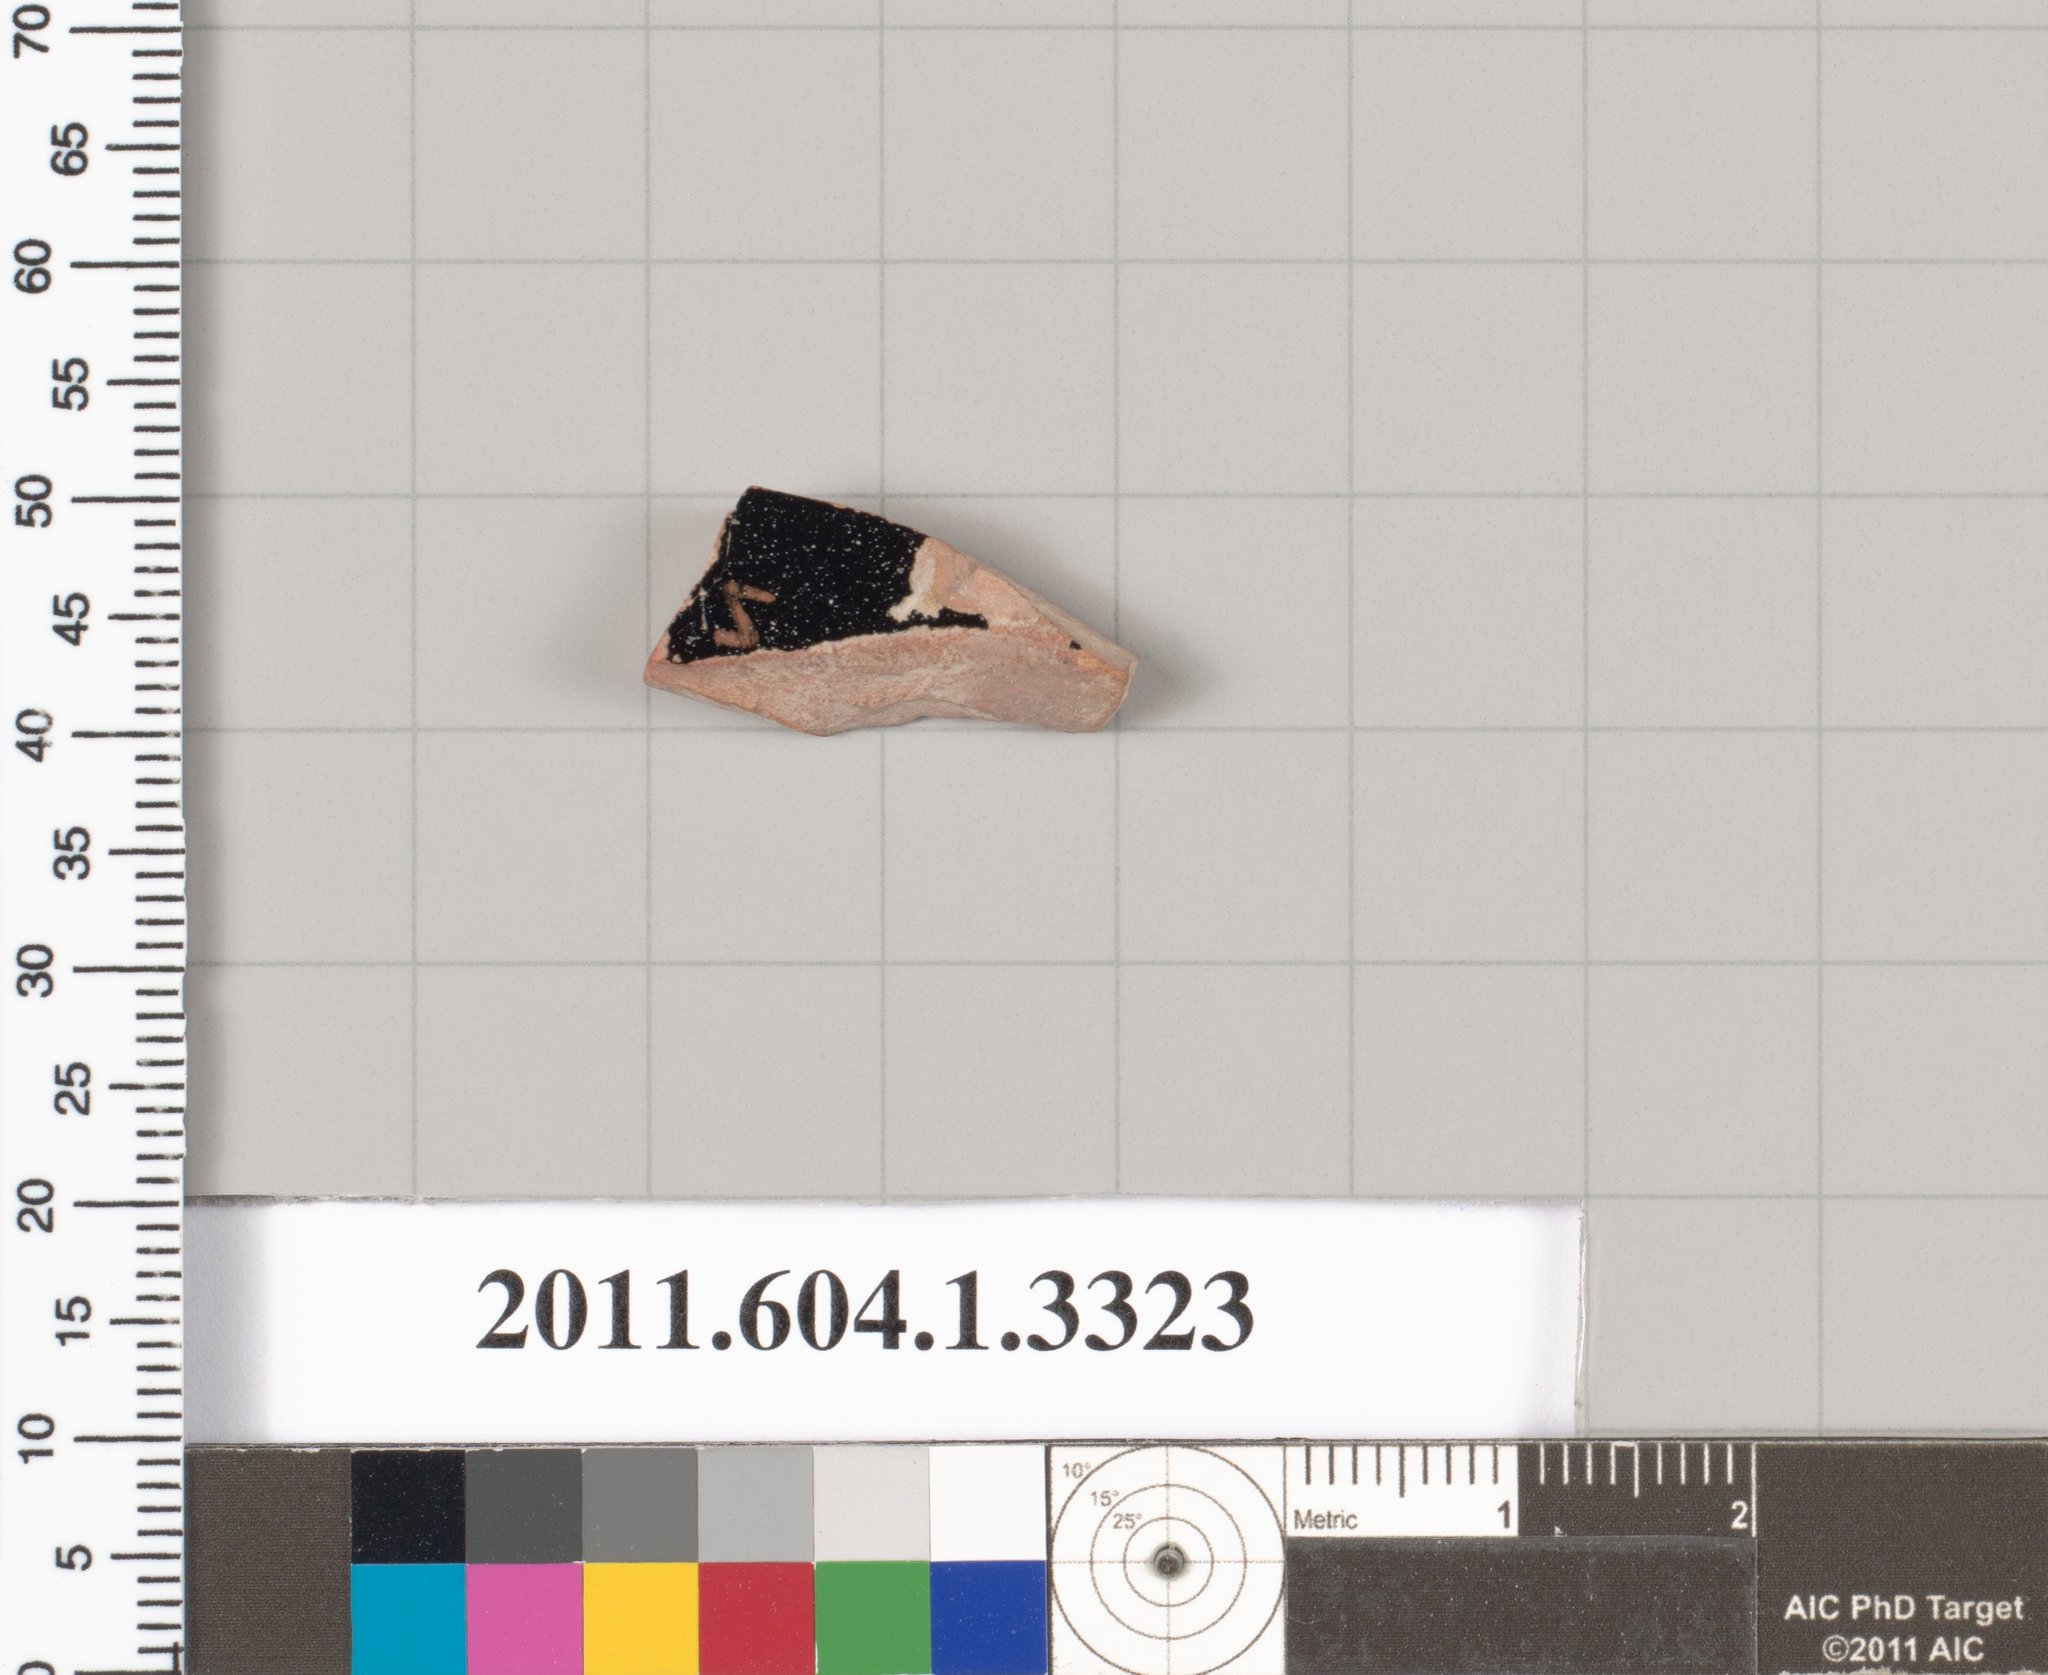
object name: kylix fragment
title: Terracotta fragment of a kylix (drinking cup)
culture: greek, attic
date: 500-470 BCE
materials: terracotta